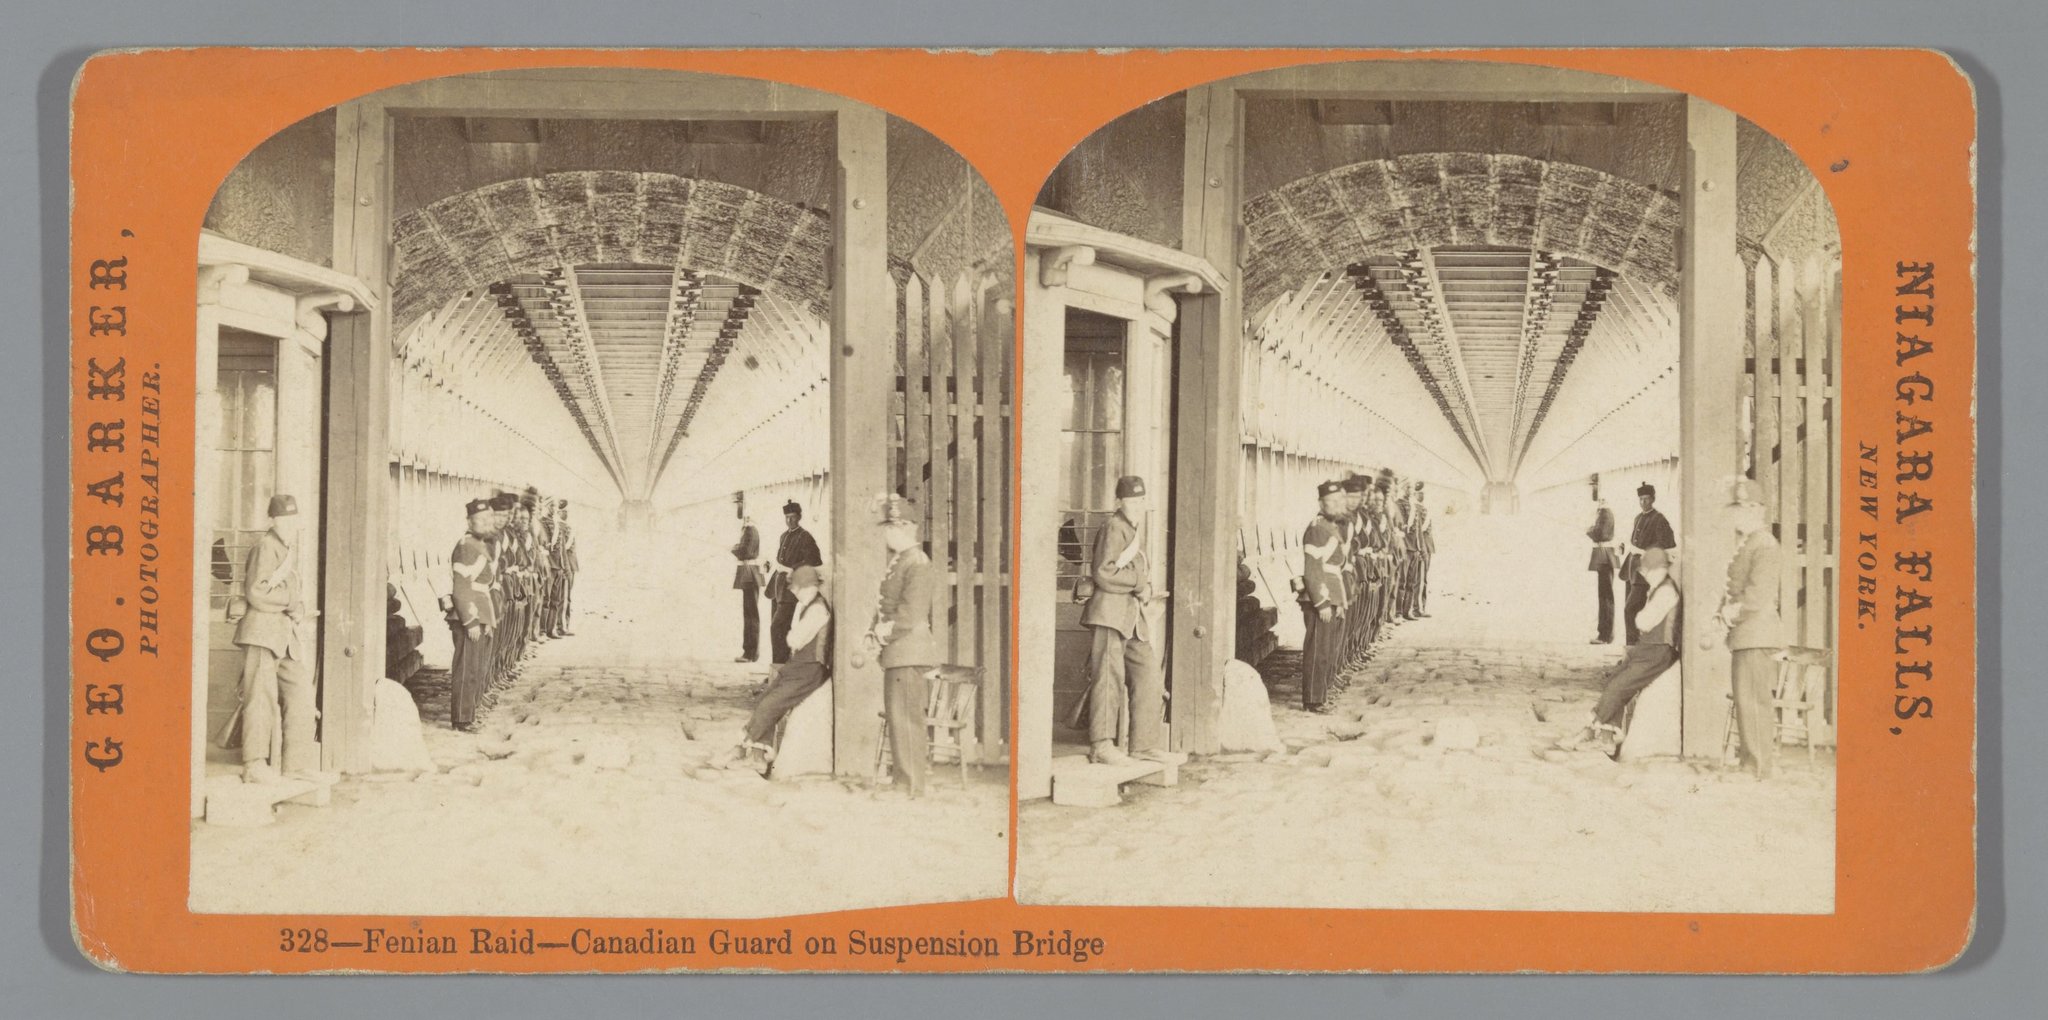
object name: stereograph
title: Canadese militairen bewaken de hangbrug nabij de Niagarawatervallen ten tijde van de Fenian Raids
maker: george barker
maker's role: fotograaf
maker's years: 1844-1894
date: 1866-1871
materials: cardboard, paper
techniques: albumen print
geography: niagara falls suspension bridge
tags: suspension bridge, guard duty, keeping sentry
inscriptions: number: ‘328’